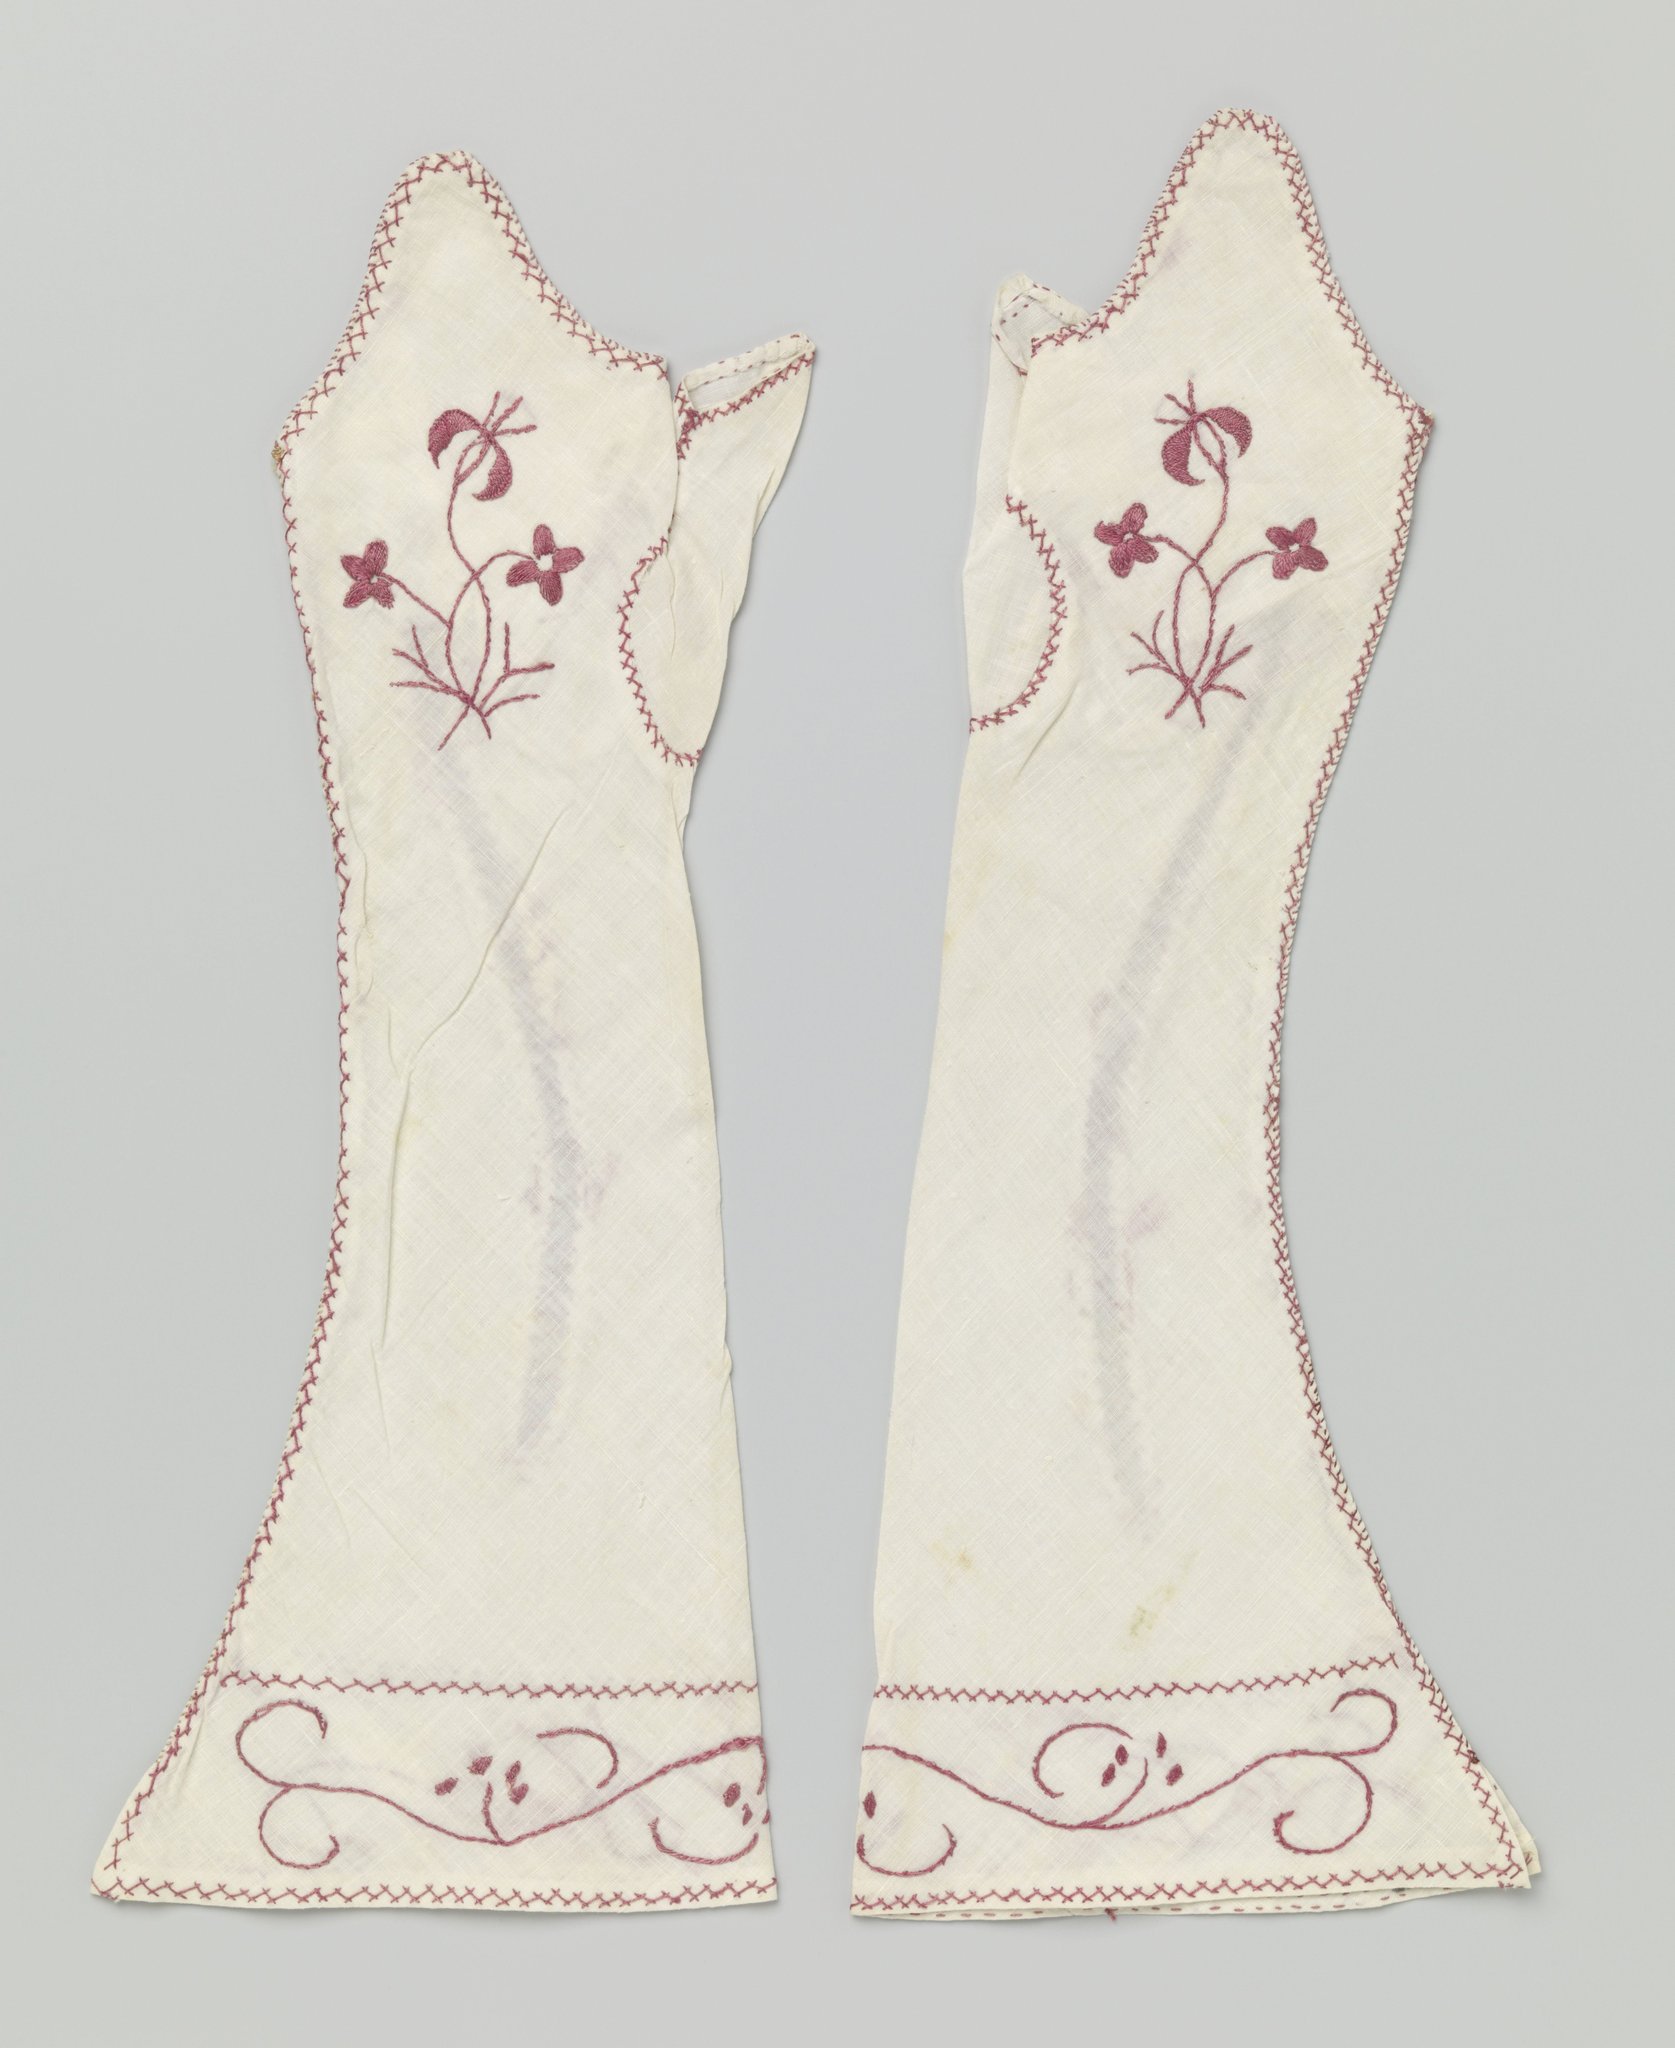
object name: mitt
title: Mitaine van wit linnen geborduurd met een floraal motief van rode vloszijde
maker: Anonymous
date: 1735-1750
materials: linen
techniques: embroidered, weave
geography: zaanstreek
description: Paar mitaines (vingerloze handschoenen) van wit linnen geborduurd met een floraal motief van rode floszijde. Model: uit één stuk geknipt, beginnend met een dek op de hand, een dichte duim en een open naad aan de onderzijde van de arm. Nauwsluitend tot aan de elleboog. Versiering: